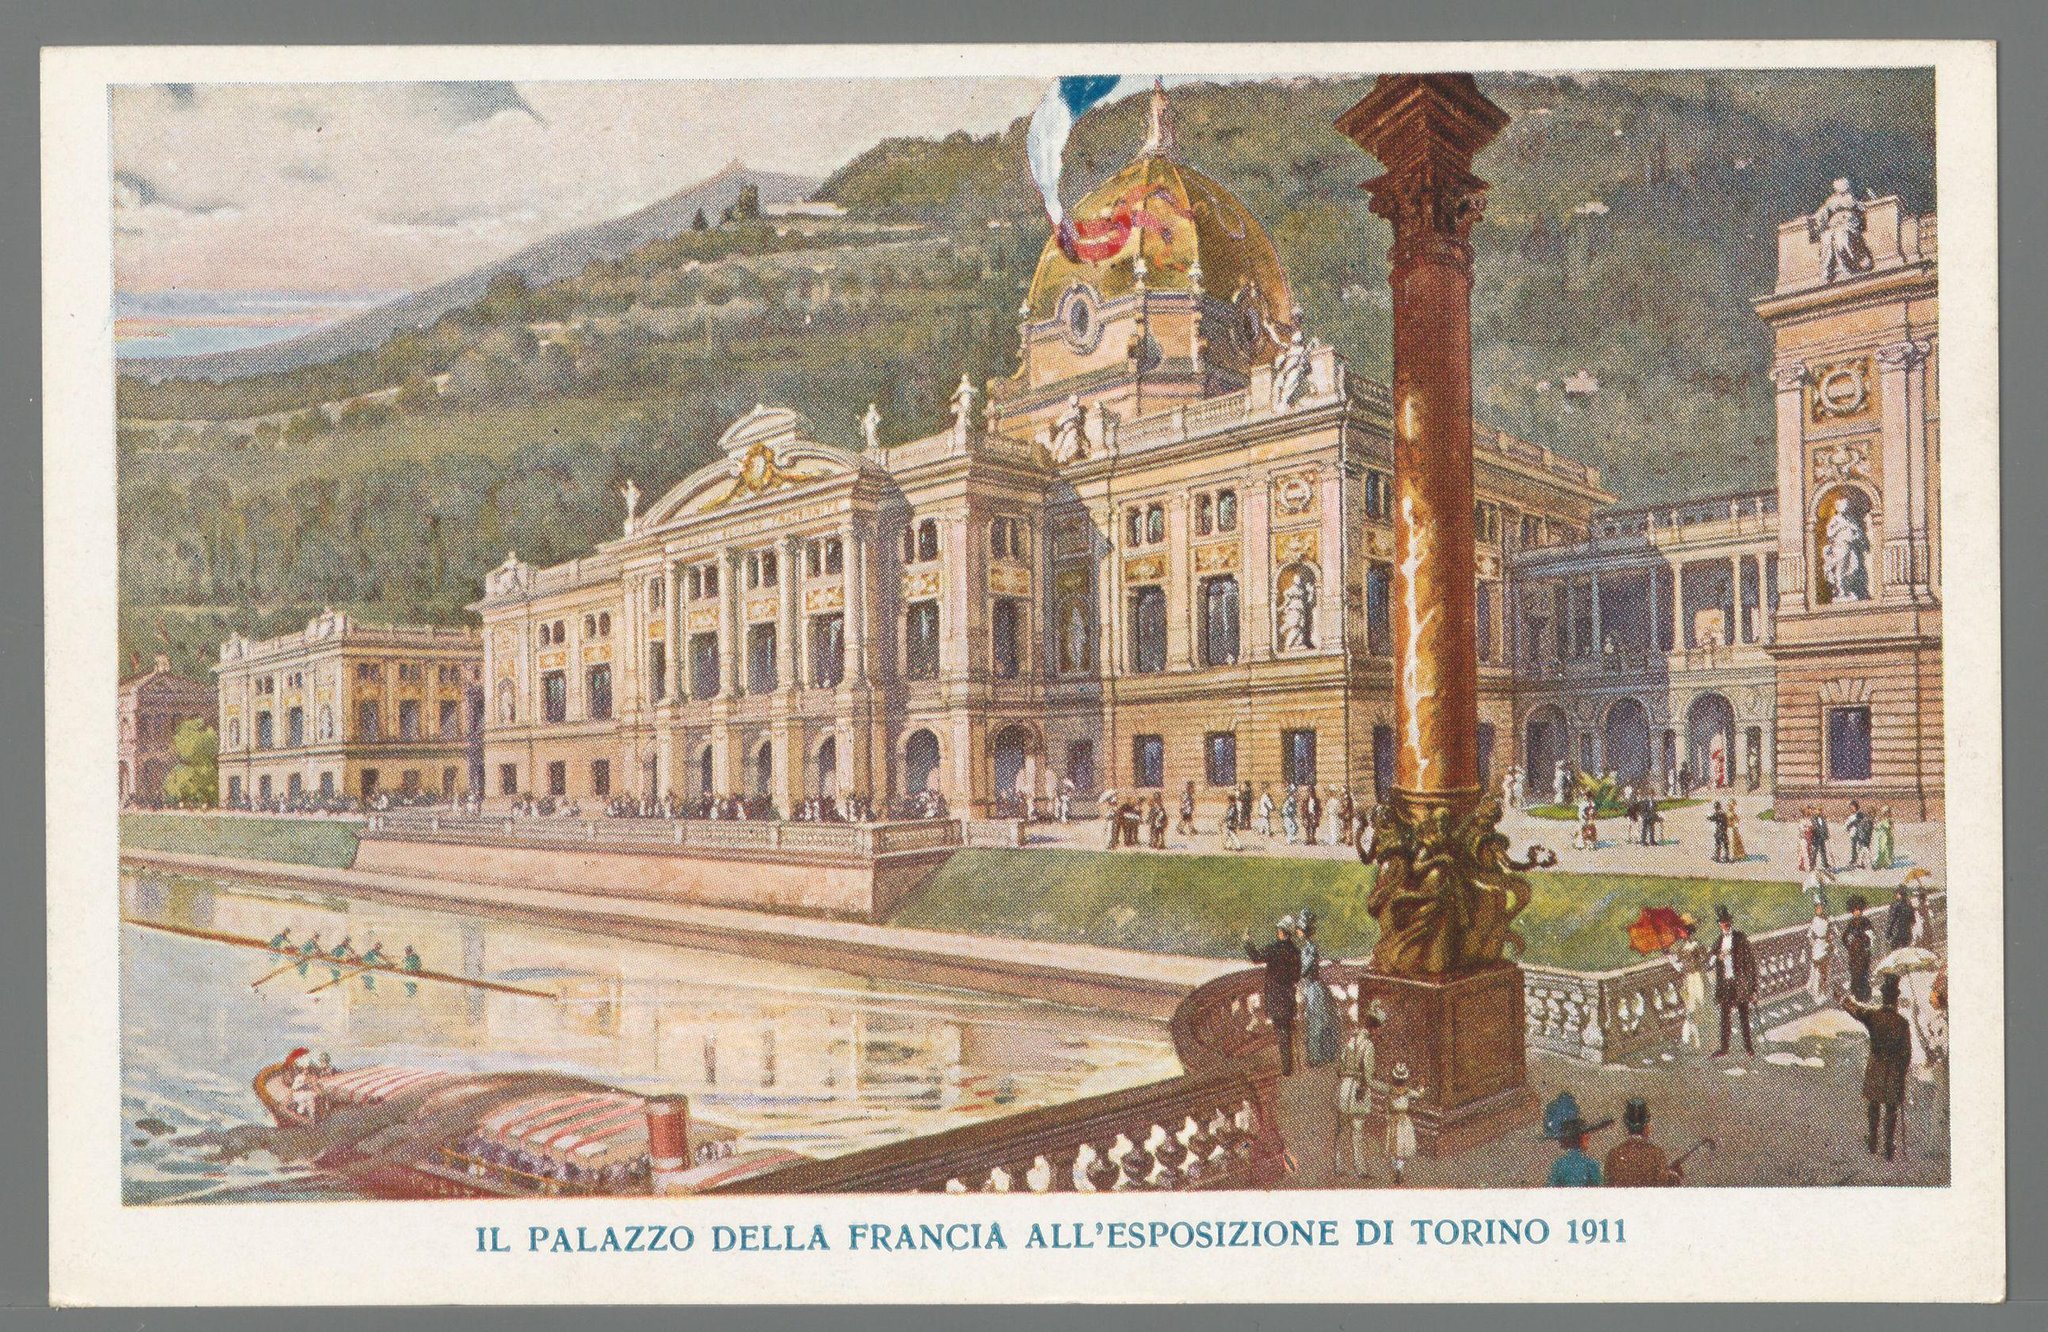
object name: photomechanical print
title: Il Palazzo della Francia all'Esposizione di Torino 1911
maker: Anonymous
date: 1910-1911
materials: cardboard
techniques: three-color autotype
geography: milan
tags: world fair, world exhibition, palace, turin international